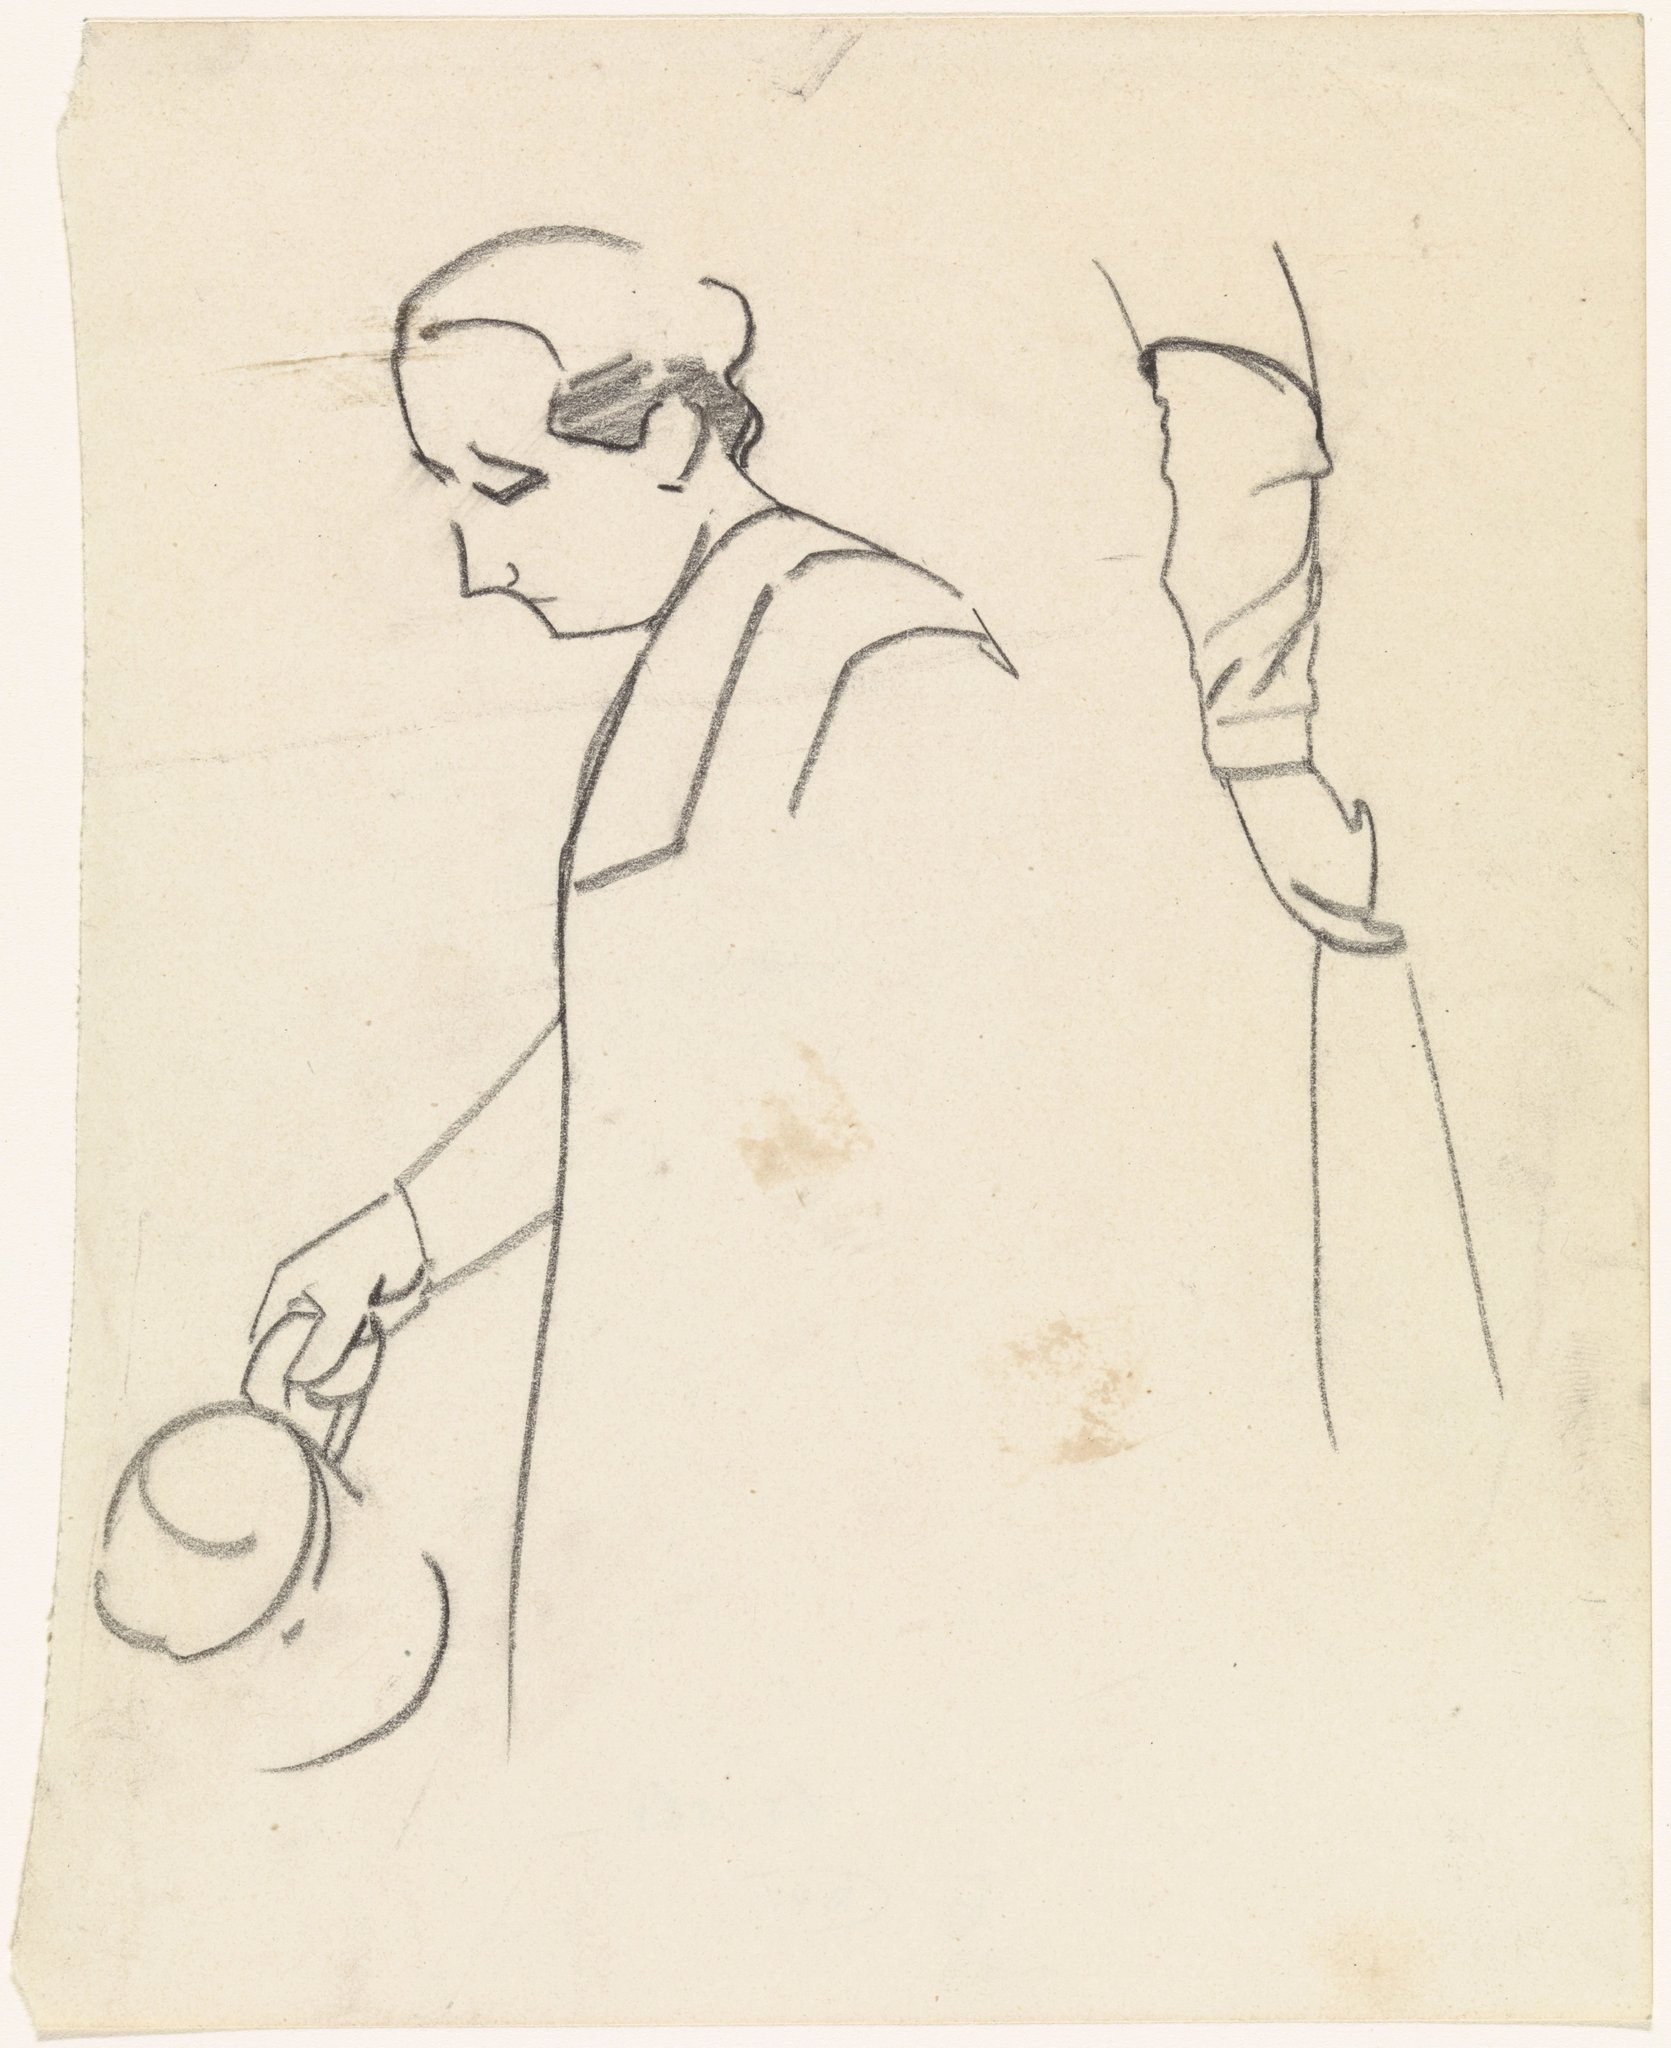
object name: drawing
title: Schets van een vrouw die planten watert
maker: gerrit willem dijsselhof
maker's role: designer, draughtsman, print maker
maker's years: 1866-1924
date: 1876-1901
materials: chalk, paper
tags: gardening